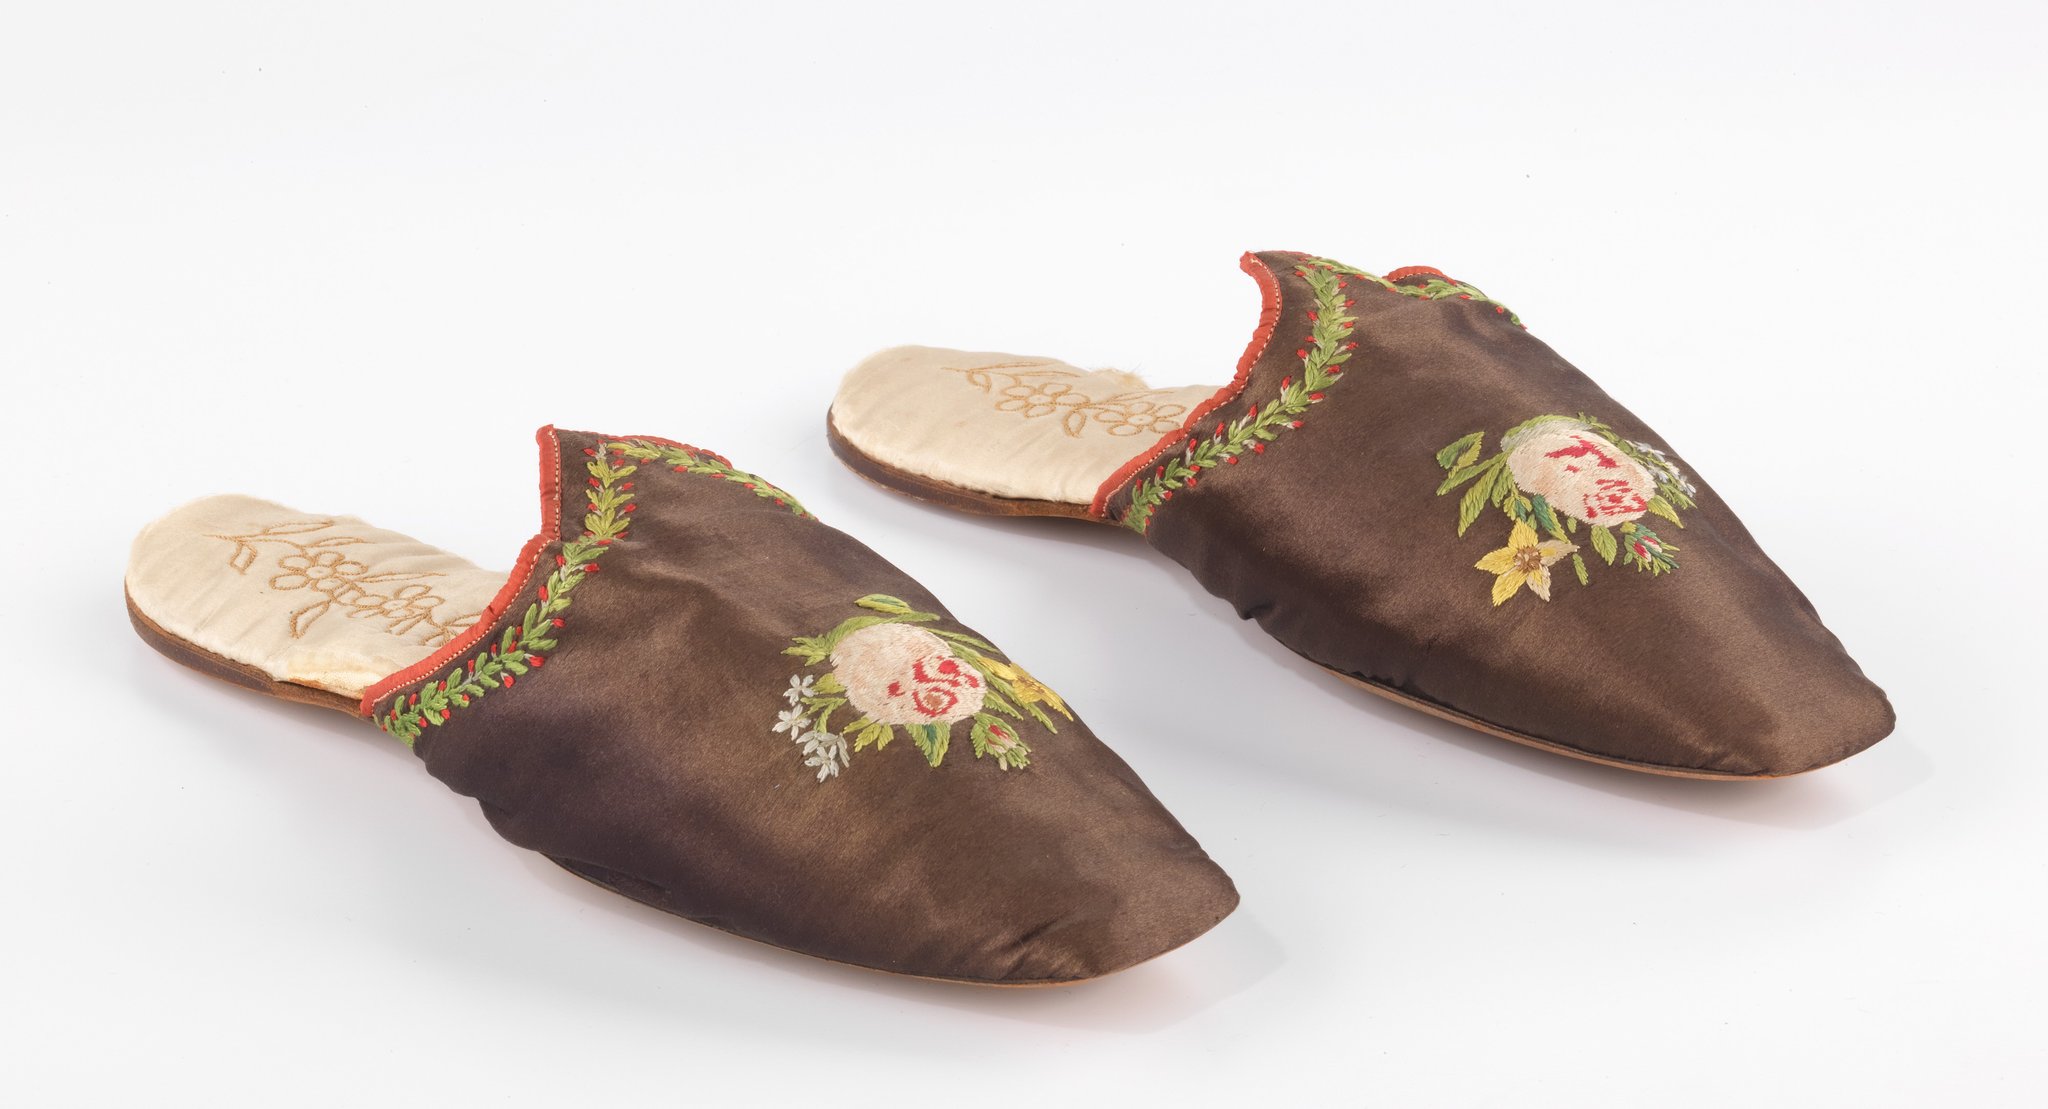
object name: slipper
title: Slippers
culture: american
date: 1835-1849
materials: silk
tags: flowers